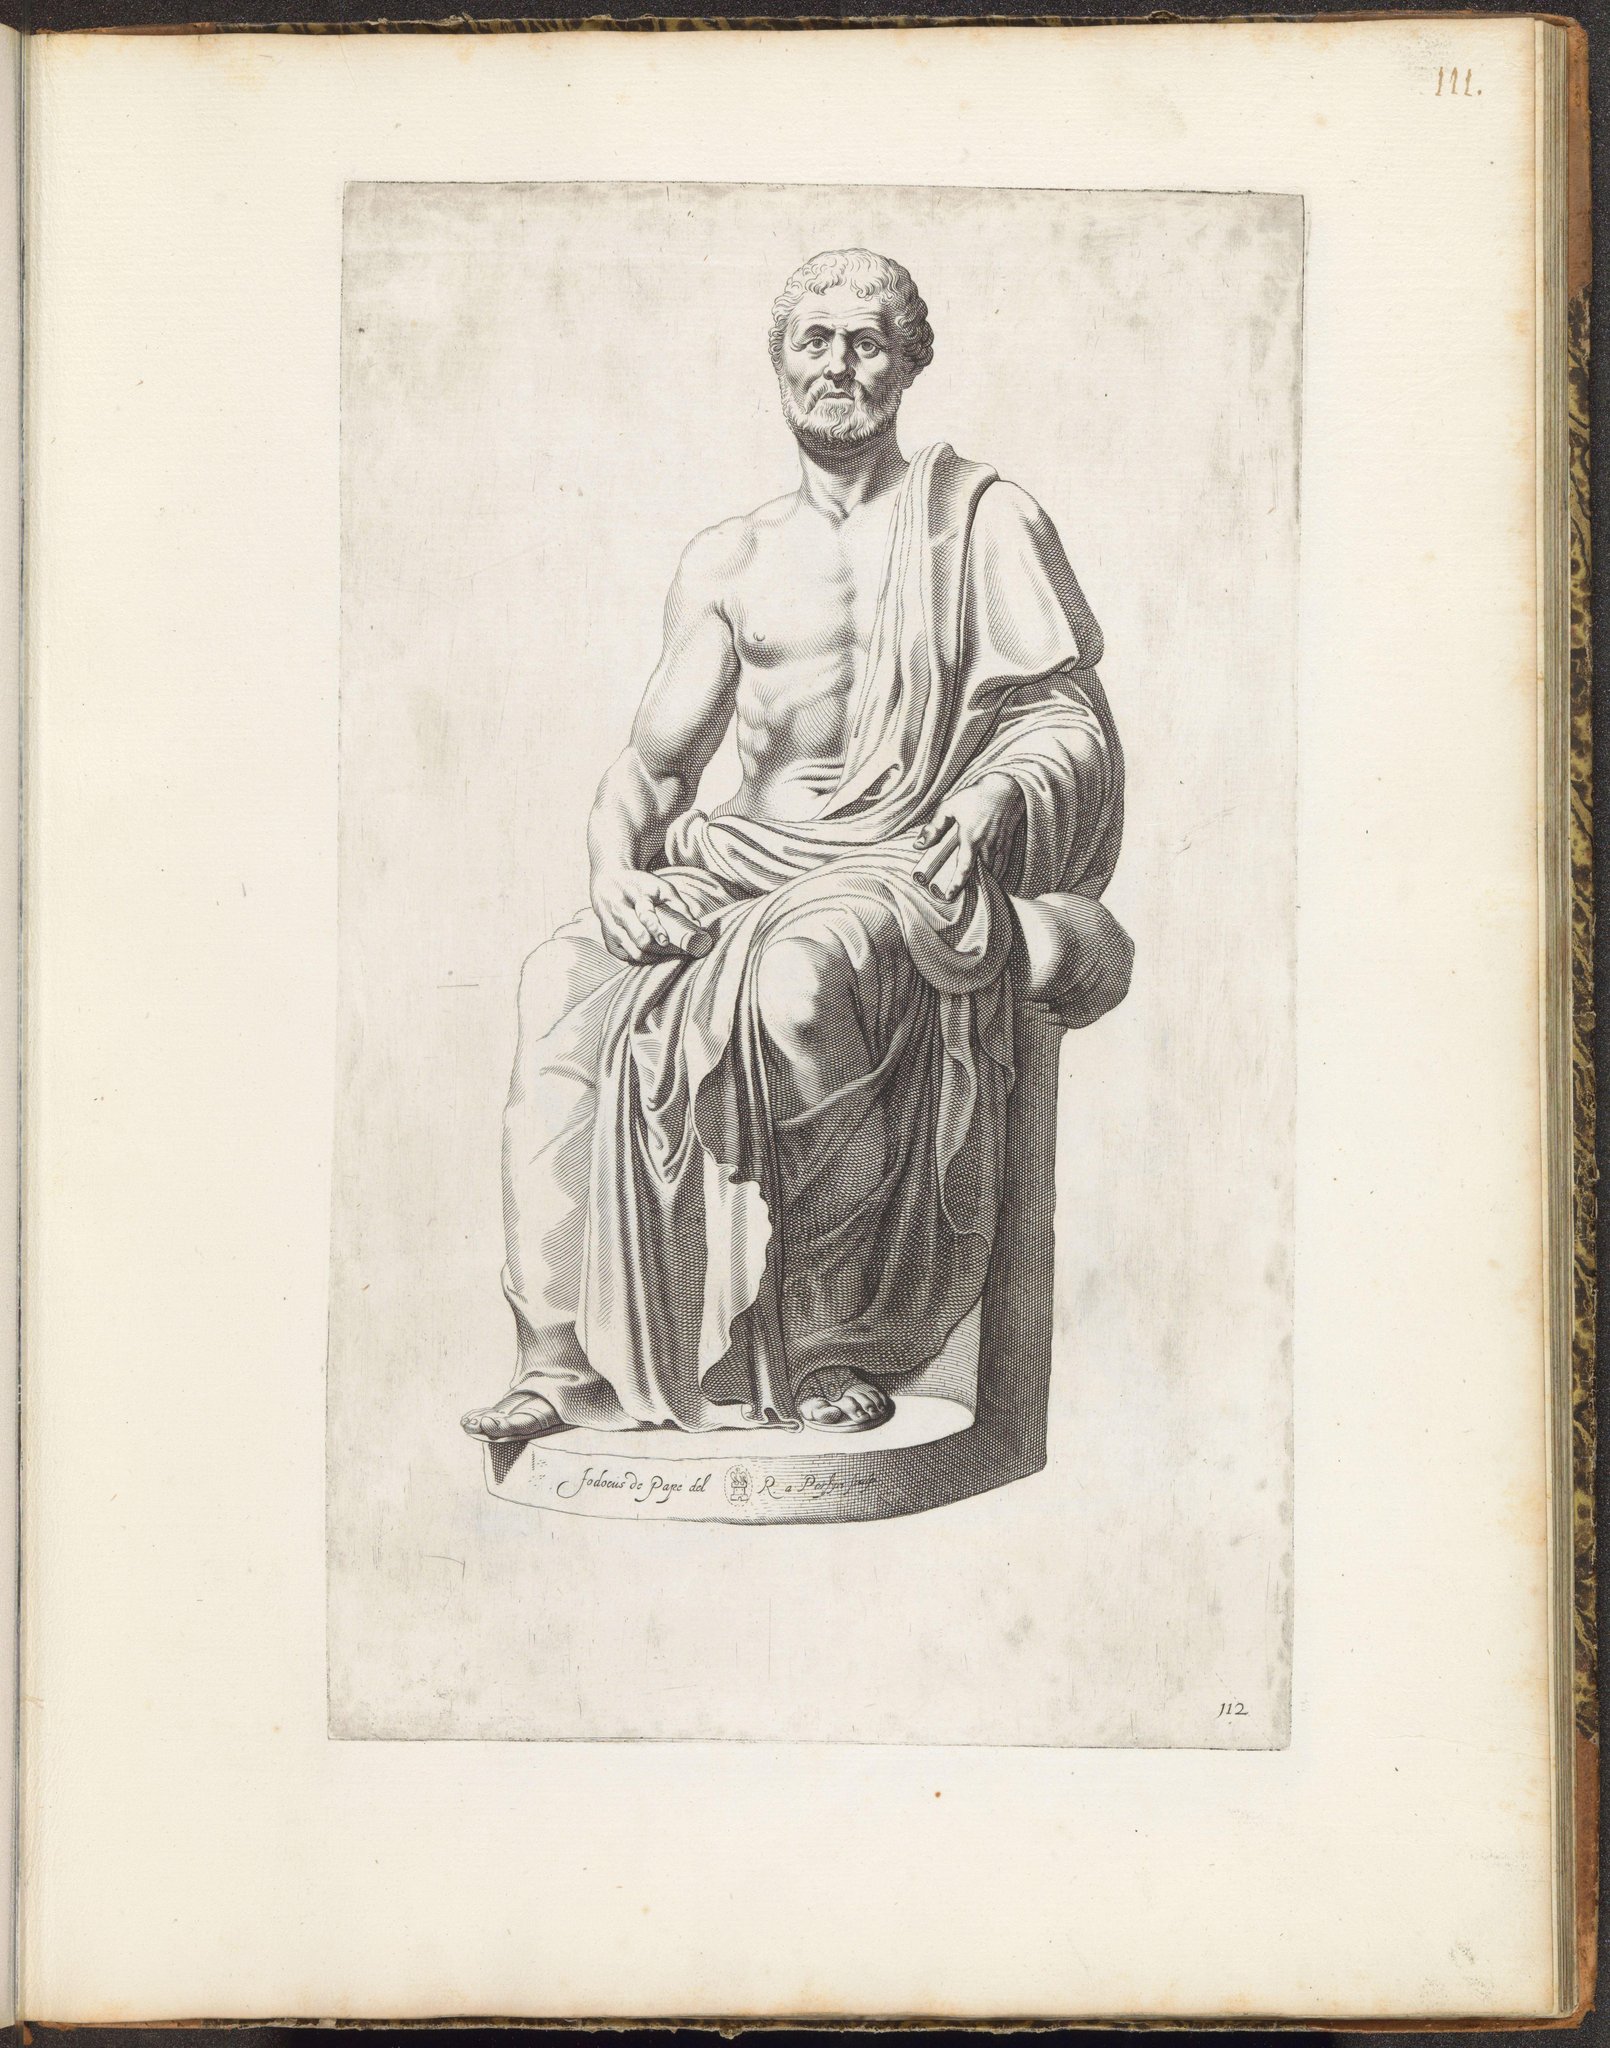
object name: album leaf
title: Standbeeld van een zittende consul of filosoof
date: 1636-1647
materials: paper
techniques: engraving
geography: rome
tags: piece of sculpture, reproduction of a piece of sculpture, male persons from classical history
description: Standbeeld van een zittende man, in klassiek gewaad, met een rol papier in de hand. Mogelijk een consul of een filosoof. Op de basis het wapenschild van Vincenzo Giustiniani. Prent maakt deel uit van een album met een serie prenten naar de sculpturen in de verzameling in de Galleria Giustiniani te Rome.